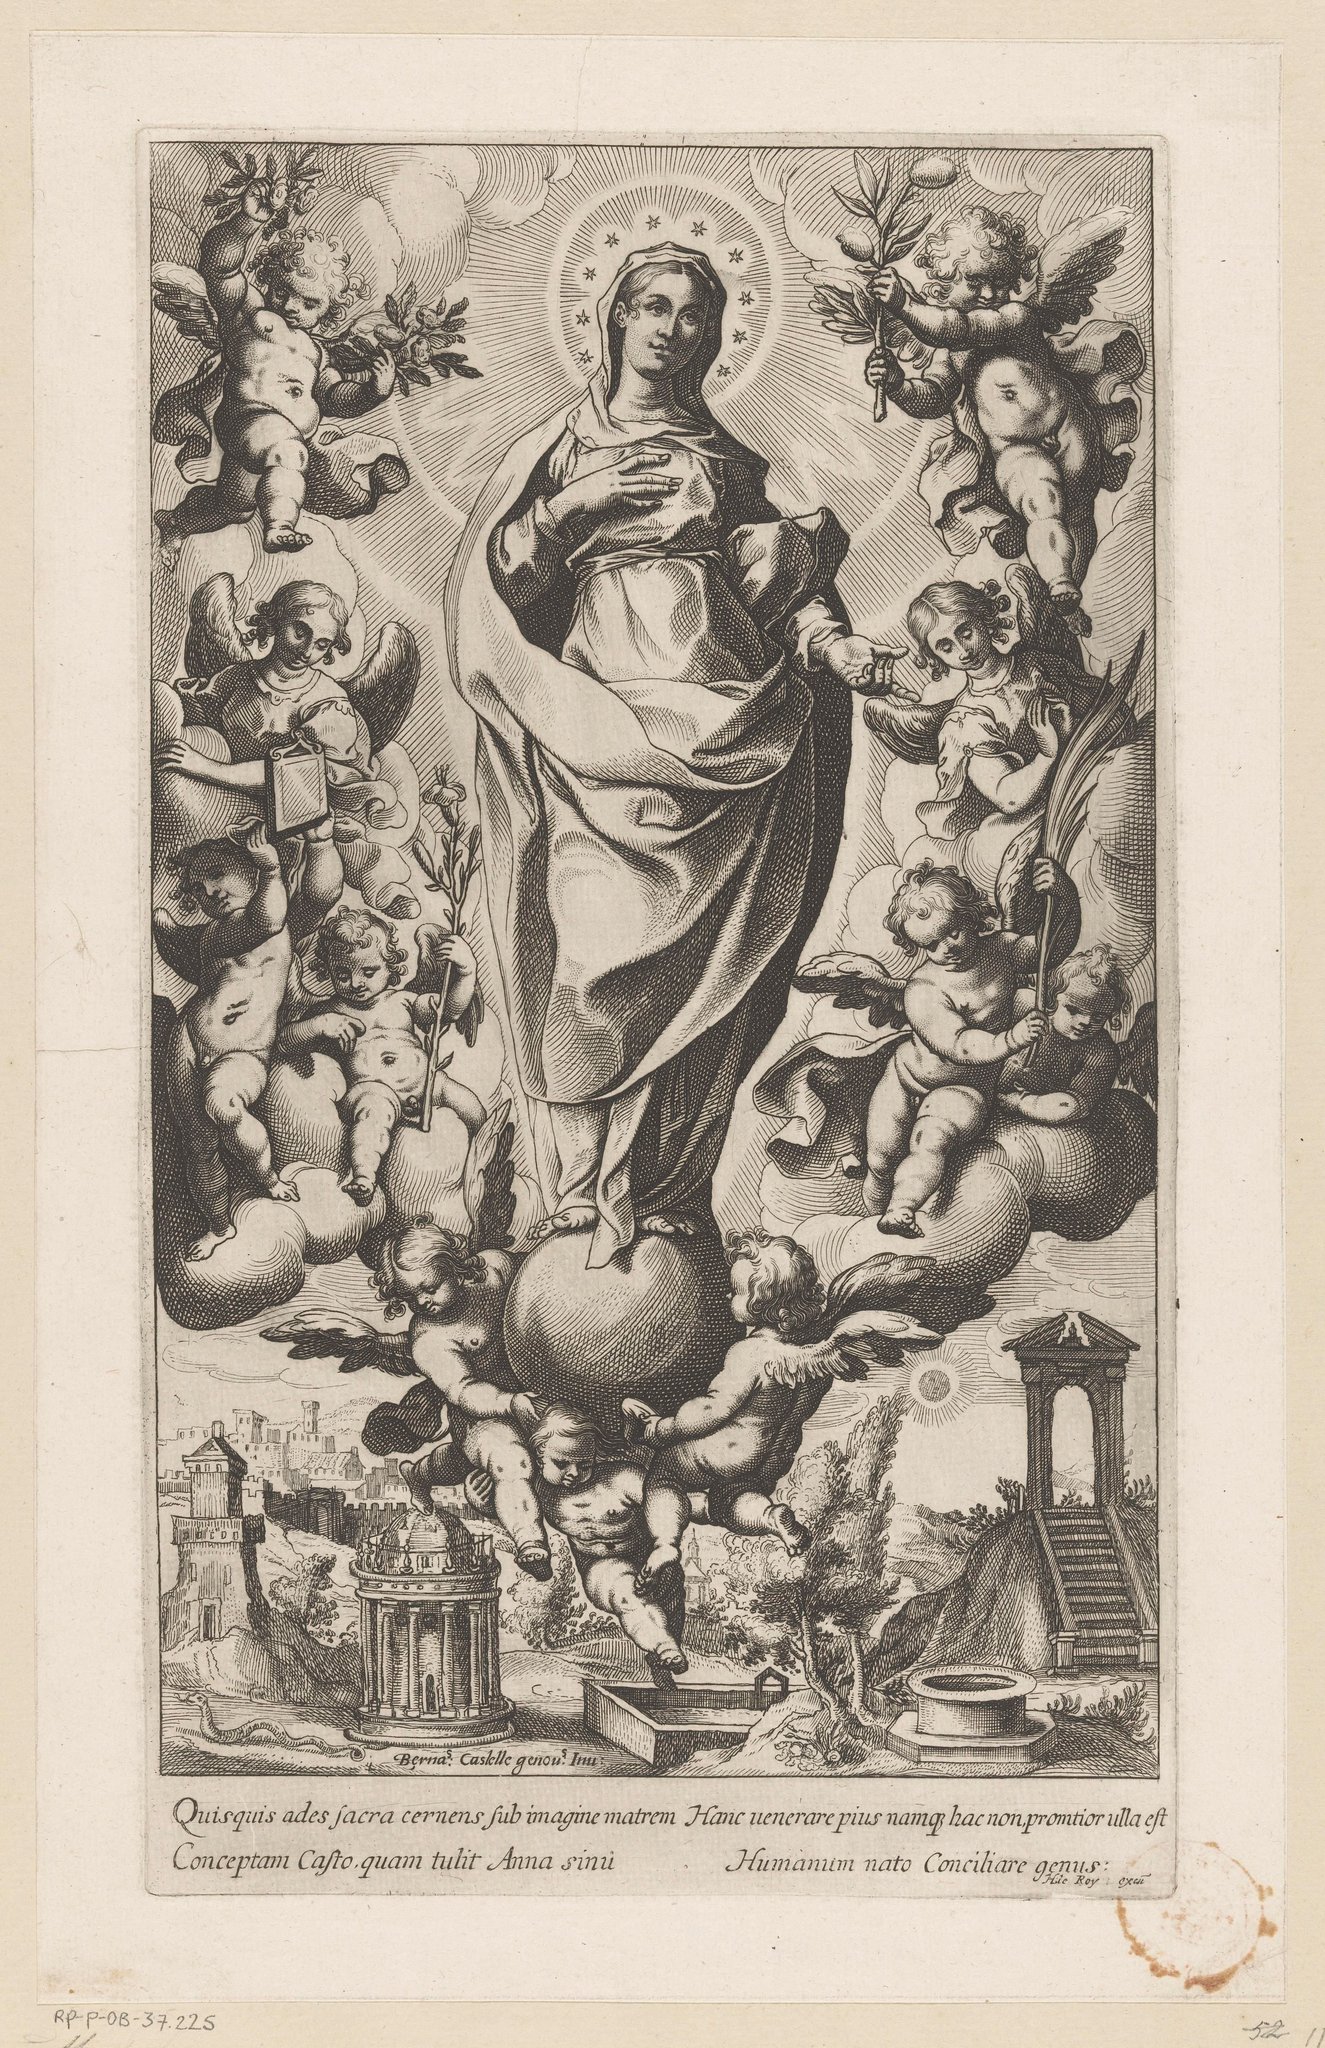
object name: print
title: Maria van de Onbevlekte Ontvangenis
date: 1589-1652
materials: paper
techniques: etching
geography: italy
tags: city-view, and landscape with man-made constructions, (immaculate) conception of mary represented symbolically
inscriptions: collector's mark: Lugt 240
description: Maria staand op een bol die wordt gedragen door drie engelen. Zij wordt omringd door engelen met de symbolen van de Onbevlekte Ontvangenis waaronder een olijftak, een lelie en een vlekkeloze spiegel. Onder Maria een landschap met een aantal bouwwerken. Twee kolommen Latijnse tekst in ondermarge.